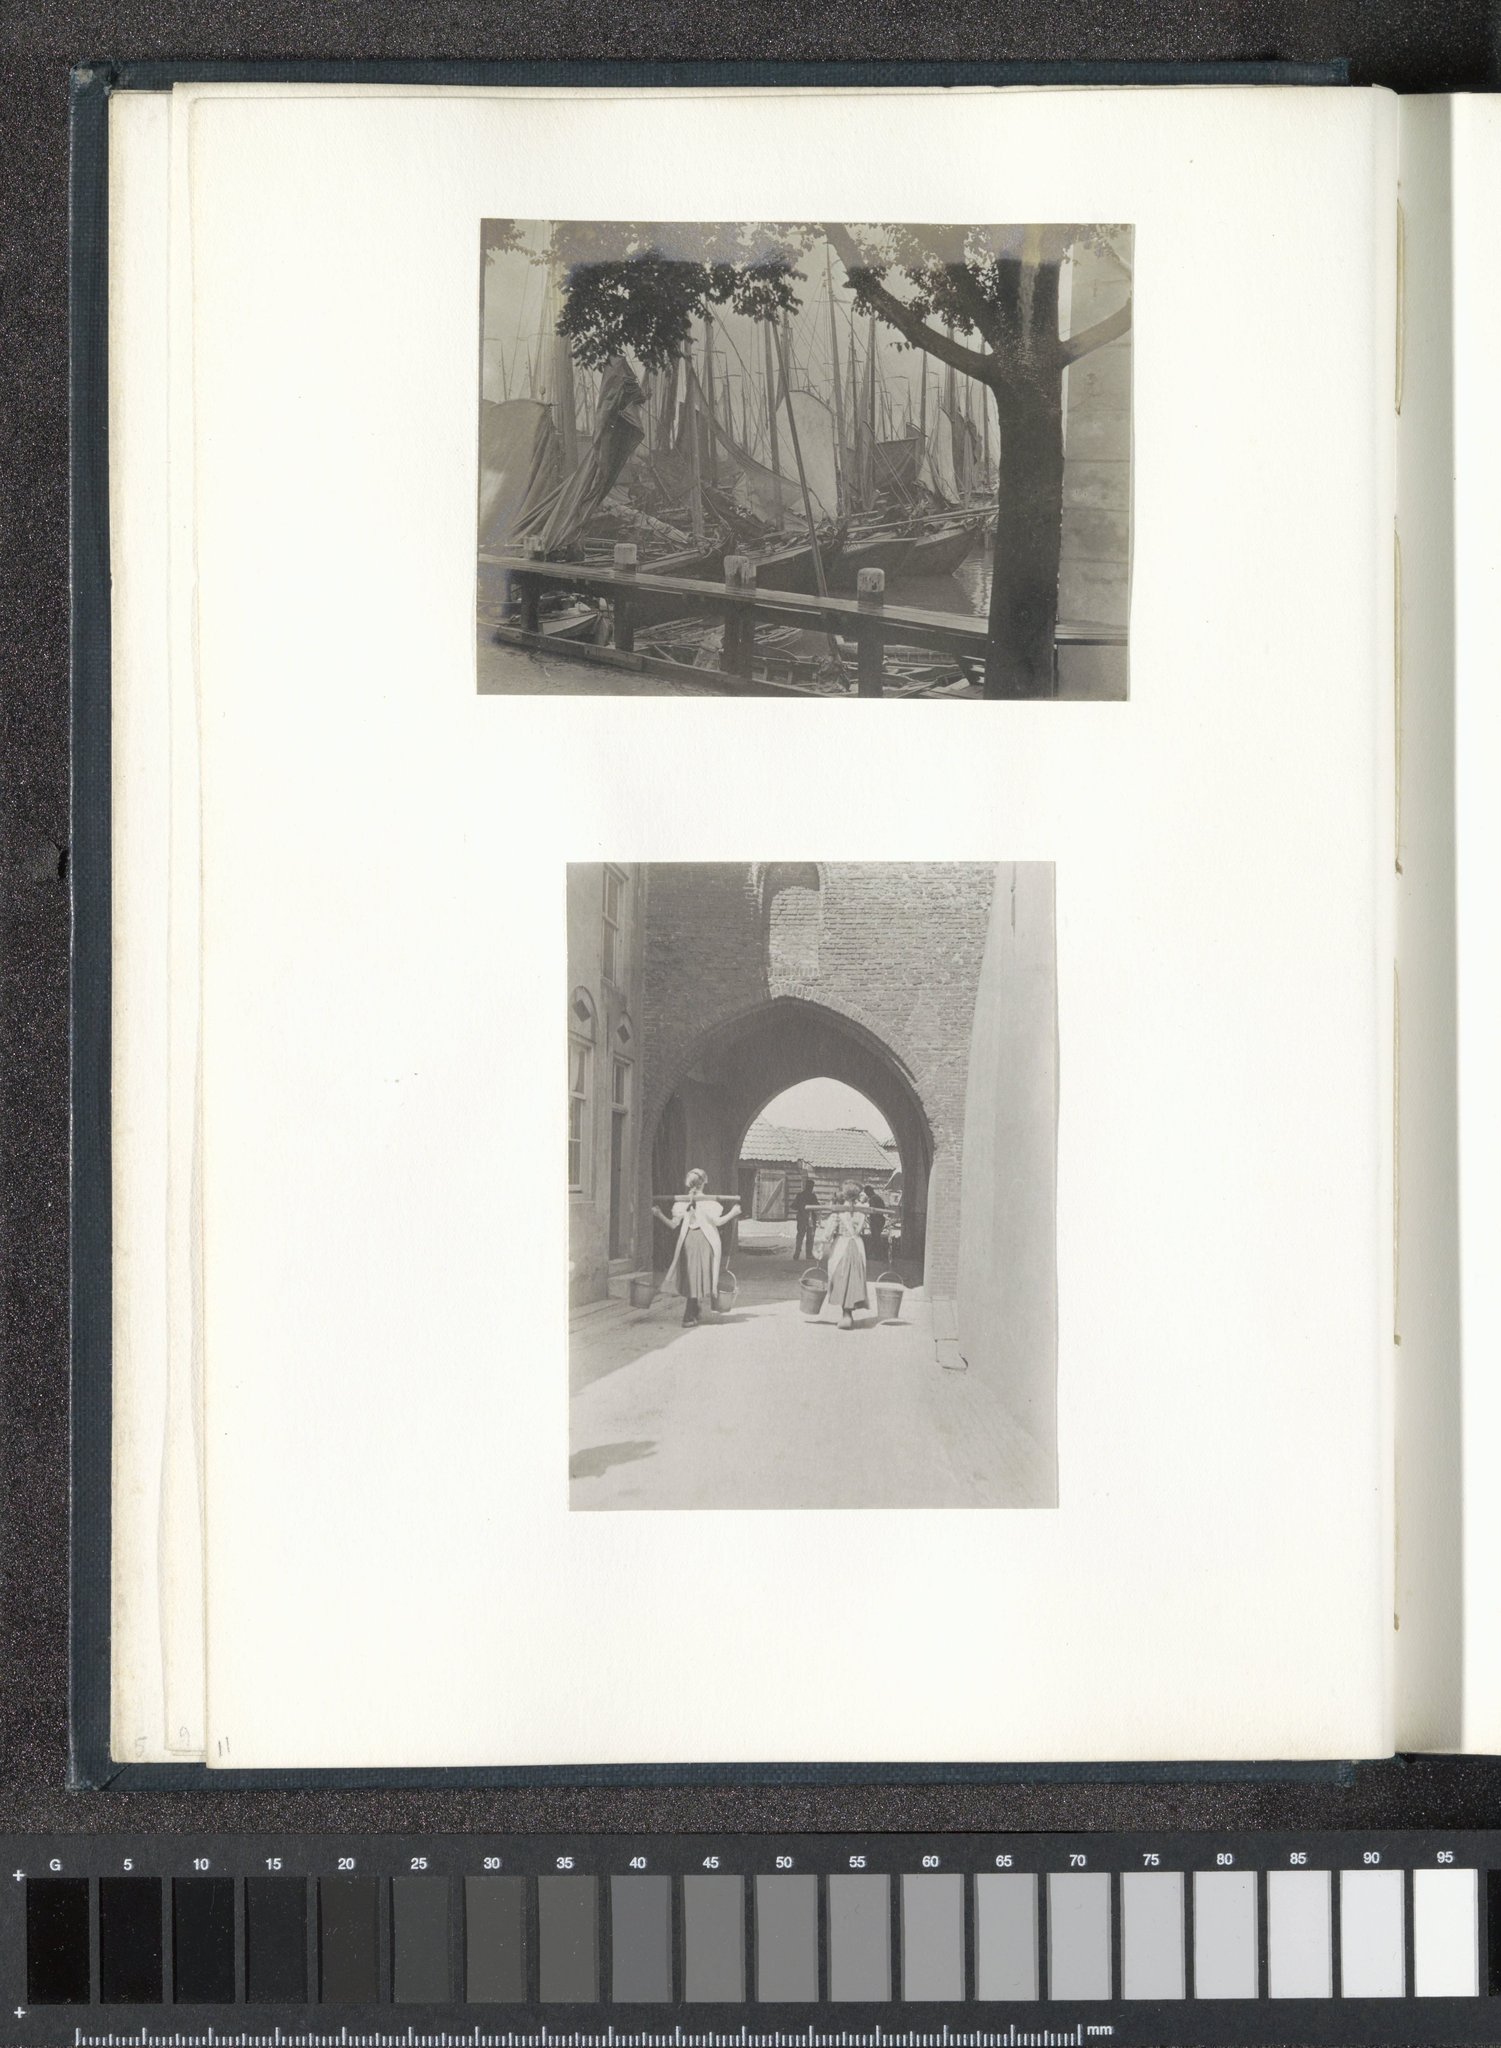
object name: photograph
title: Zeilschepen in een haven, vermoedelijk in Volendam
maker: george hidderley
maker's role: fotograaf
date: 1900-1910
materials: paper, photographic support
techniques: gelatin silver print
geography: volendam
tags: sailing-ship, sailing-boat, harbour (+ view ~ vehicle, ship, etc.)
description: Onderdeel van fotoalbum met opnames van Volendam, Dordrecht, Gorinchem en Woudrichem.